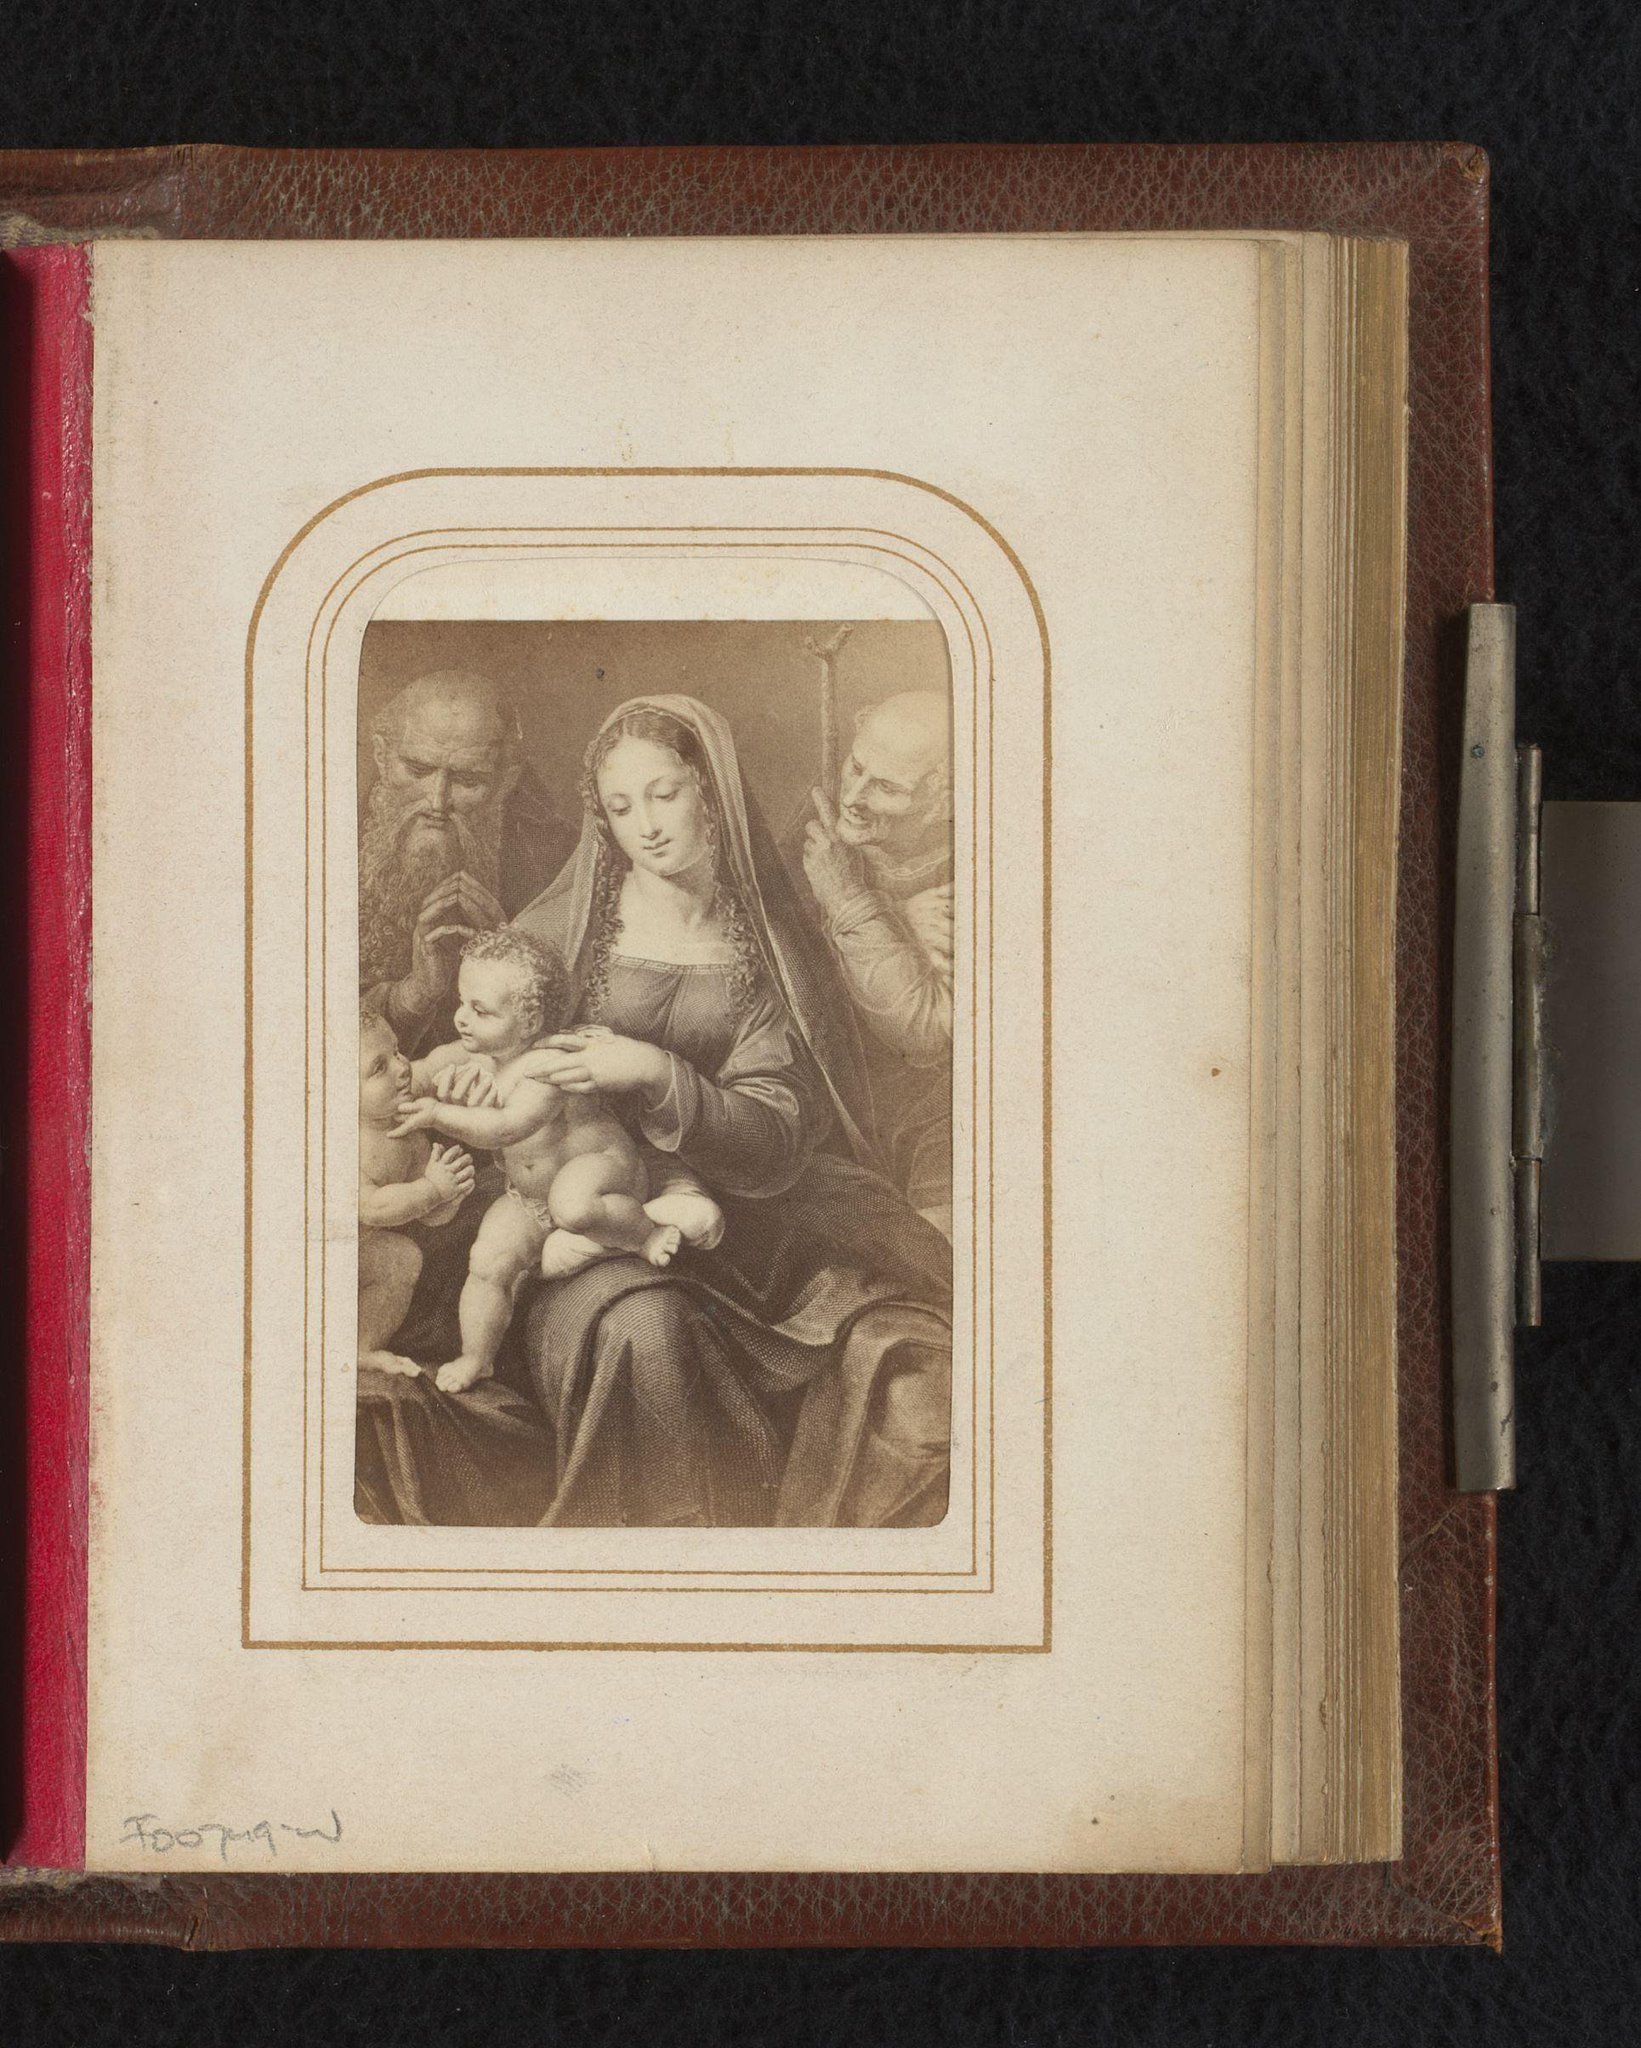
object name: reproduction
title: Fotoreproductie van een prent met Maria, Christus en Johannes de Doper door François Forster naar Leonardo da Vinci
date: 1865-1900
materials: cardboard, photographic support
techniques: albumen print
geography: berlin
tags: madonna (i.e. mary with the christ-child) accompanied or surrounded by others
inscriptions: inscription: ‘da Vinzi:/ Vierge au basrelief/ 405./ Gustav Schauer/ Photographisches Kunst- und Verlags - Institut/ Berlin/ Grosse Friedrichs - Strasse 188’